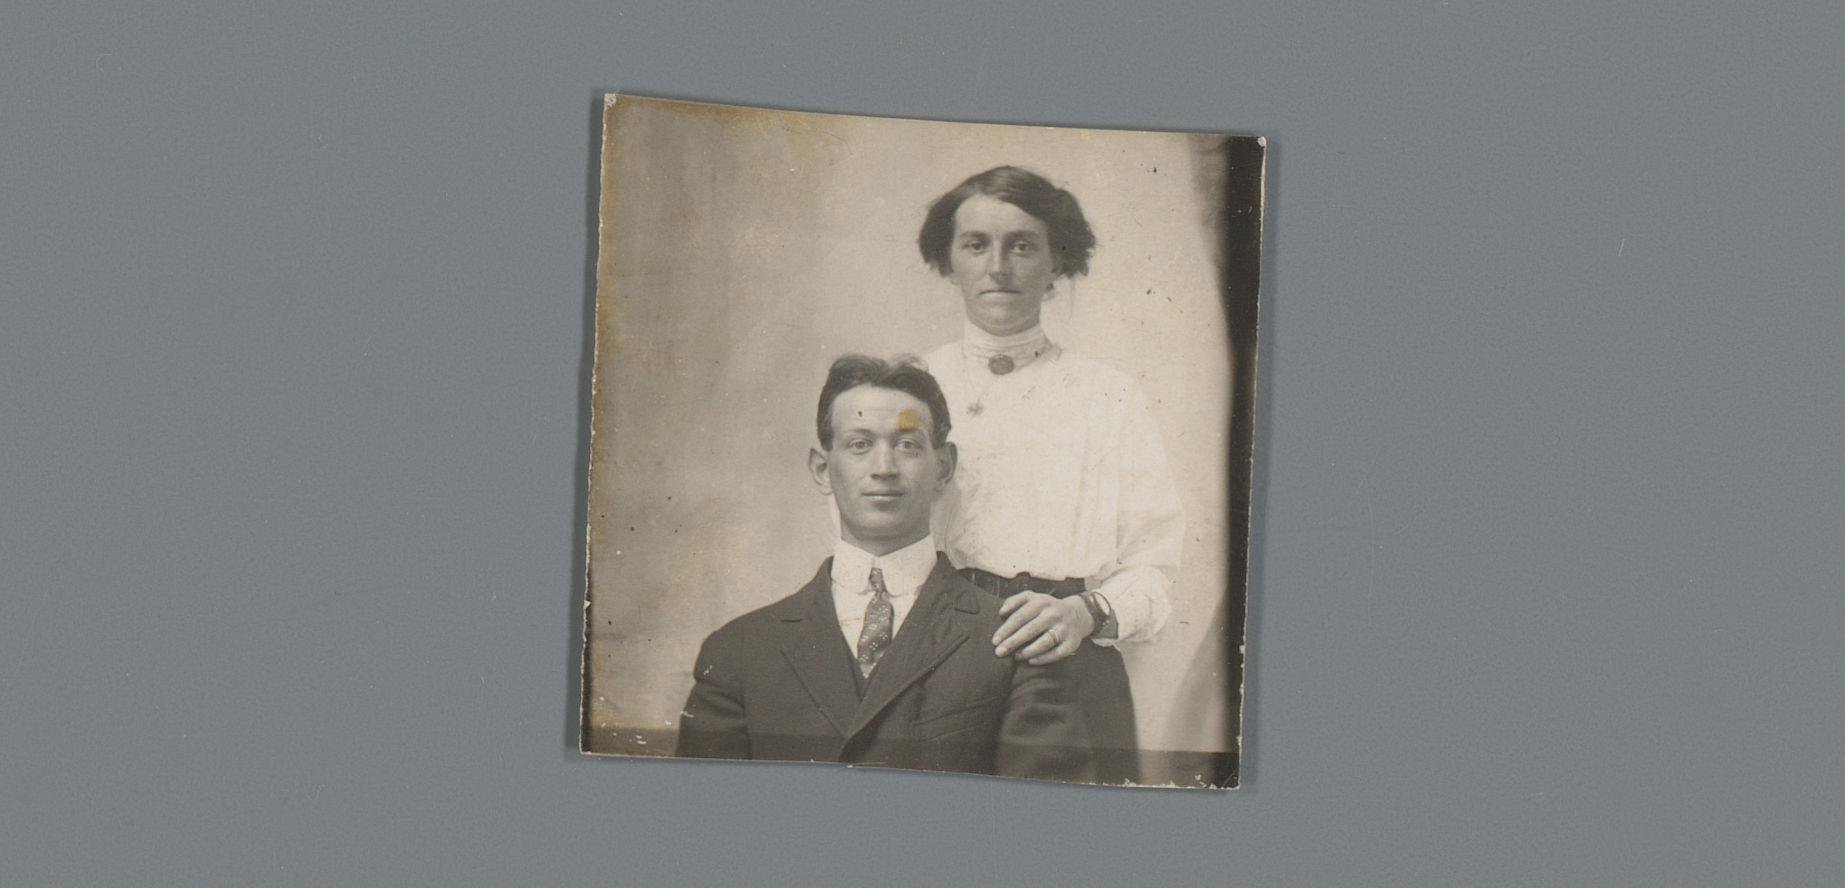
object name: snapshot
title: Rapid photographs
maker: Anonymous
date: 1912-1920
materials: paper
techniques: gelatin silver print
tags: adult woman, adult man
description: Between 1912 and 1930, anyone could have their portrait taken at the many so-called rapid photography studios in the shopping streets of mainly (medium) large-size European cities. As if on an assembly line, the youngest clerk shot the photographs with a special camera and in artificial light and developed them. Later in the day, the customer collected a sheet with 12 portrait photos for 25 cents. This form of photographic mass production gave rise to a fascinating tableau of boys, girls, men and women not previously seen in photographs; candid and informal. There were at least 150 quick-photo studios, from Alkmaar to Zutphen. Many called themselves ‘American,’ mistakenly as it turns out because hardly any examples from that country have been found.